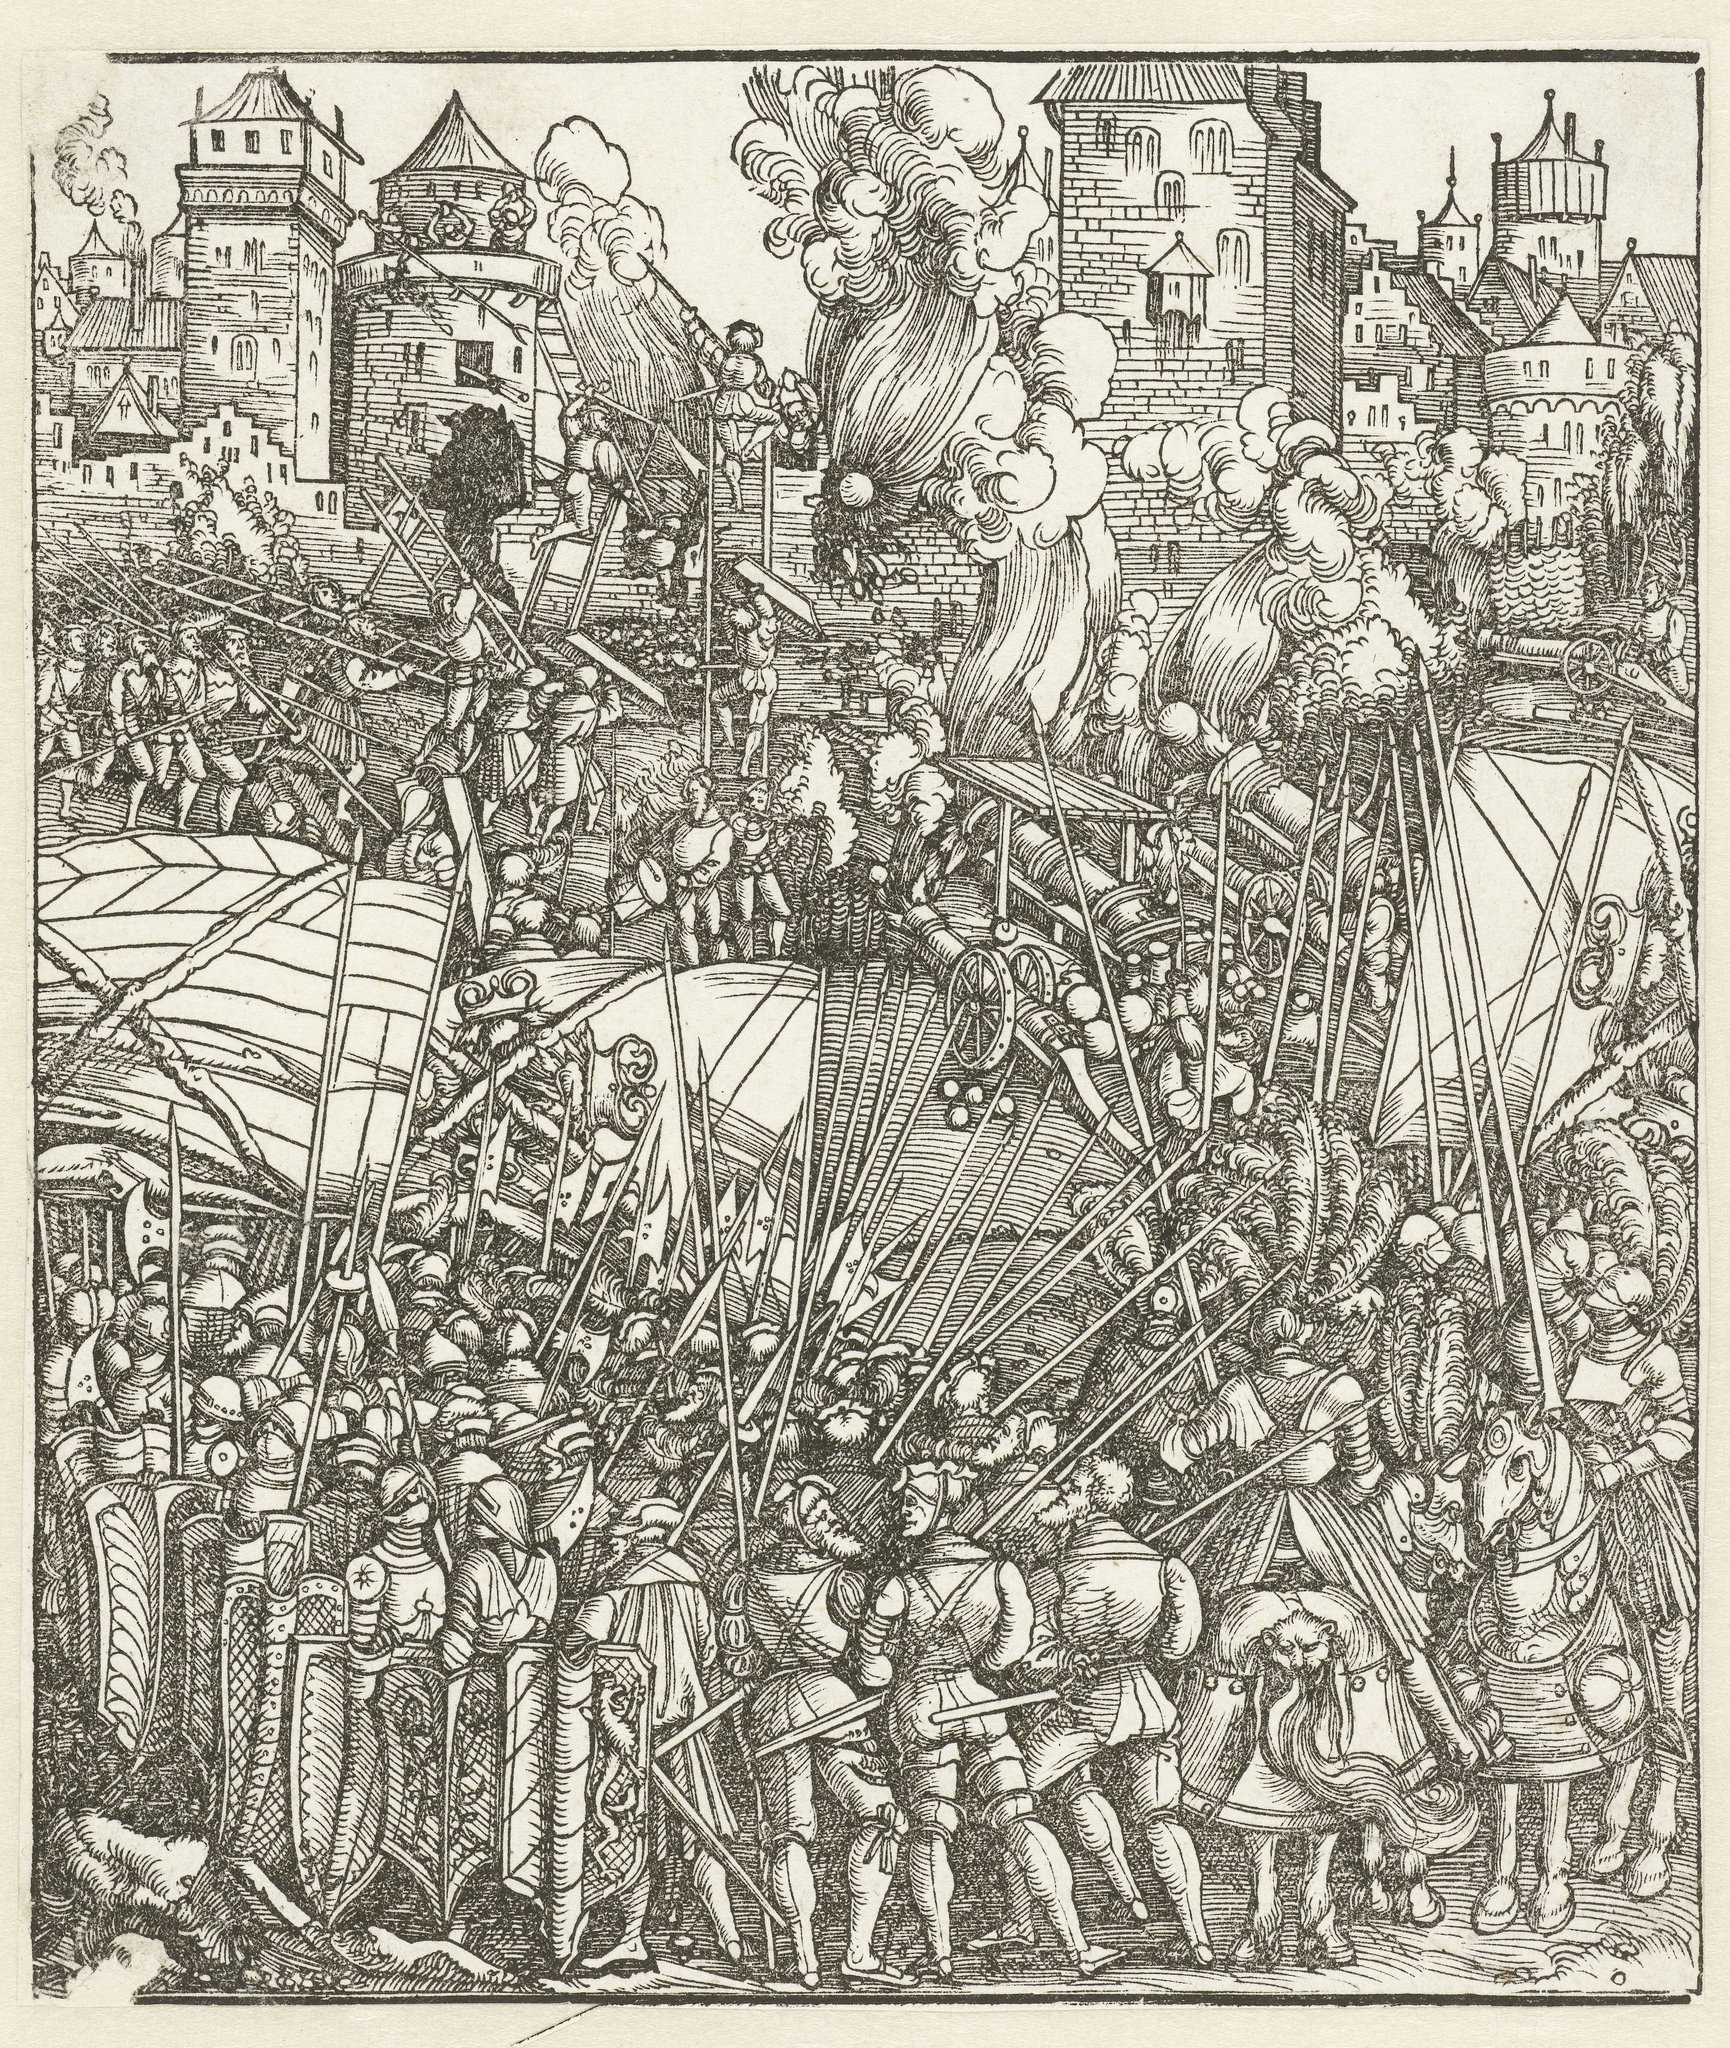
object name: print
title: Verdrijving van de Hongaren uit Oostenrijk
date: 1515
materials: paper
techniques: woodcut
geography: nuremberg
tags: maximilian i (holy roman emperor), insignia of companies, etc., attack ~ siege, austria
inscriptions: collector's mark: Lugt 240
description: Een stad wordt zwaar onder vuur genomen en bestormd door de troepen van Maximiliaan. Detail van de triomfboog van keizer Maximiliaan I.